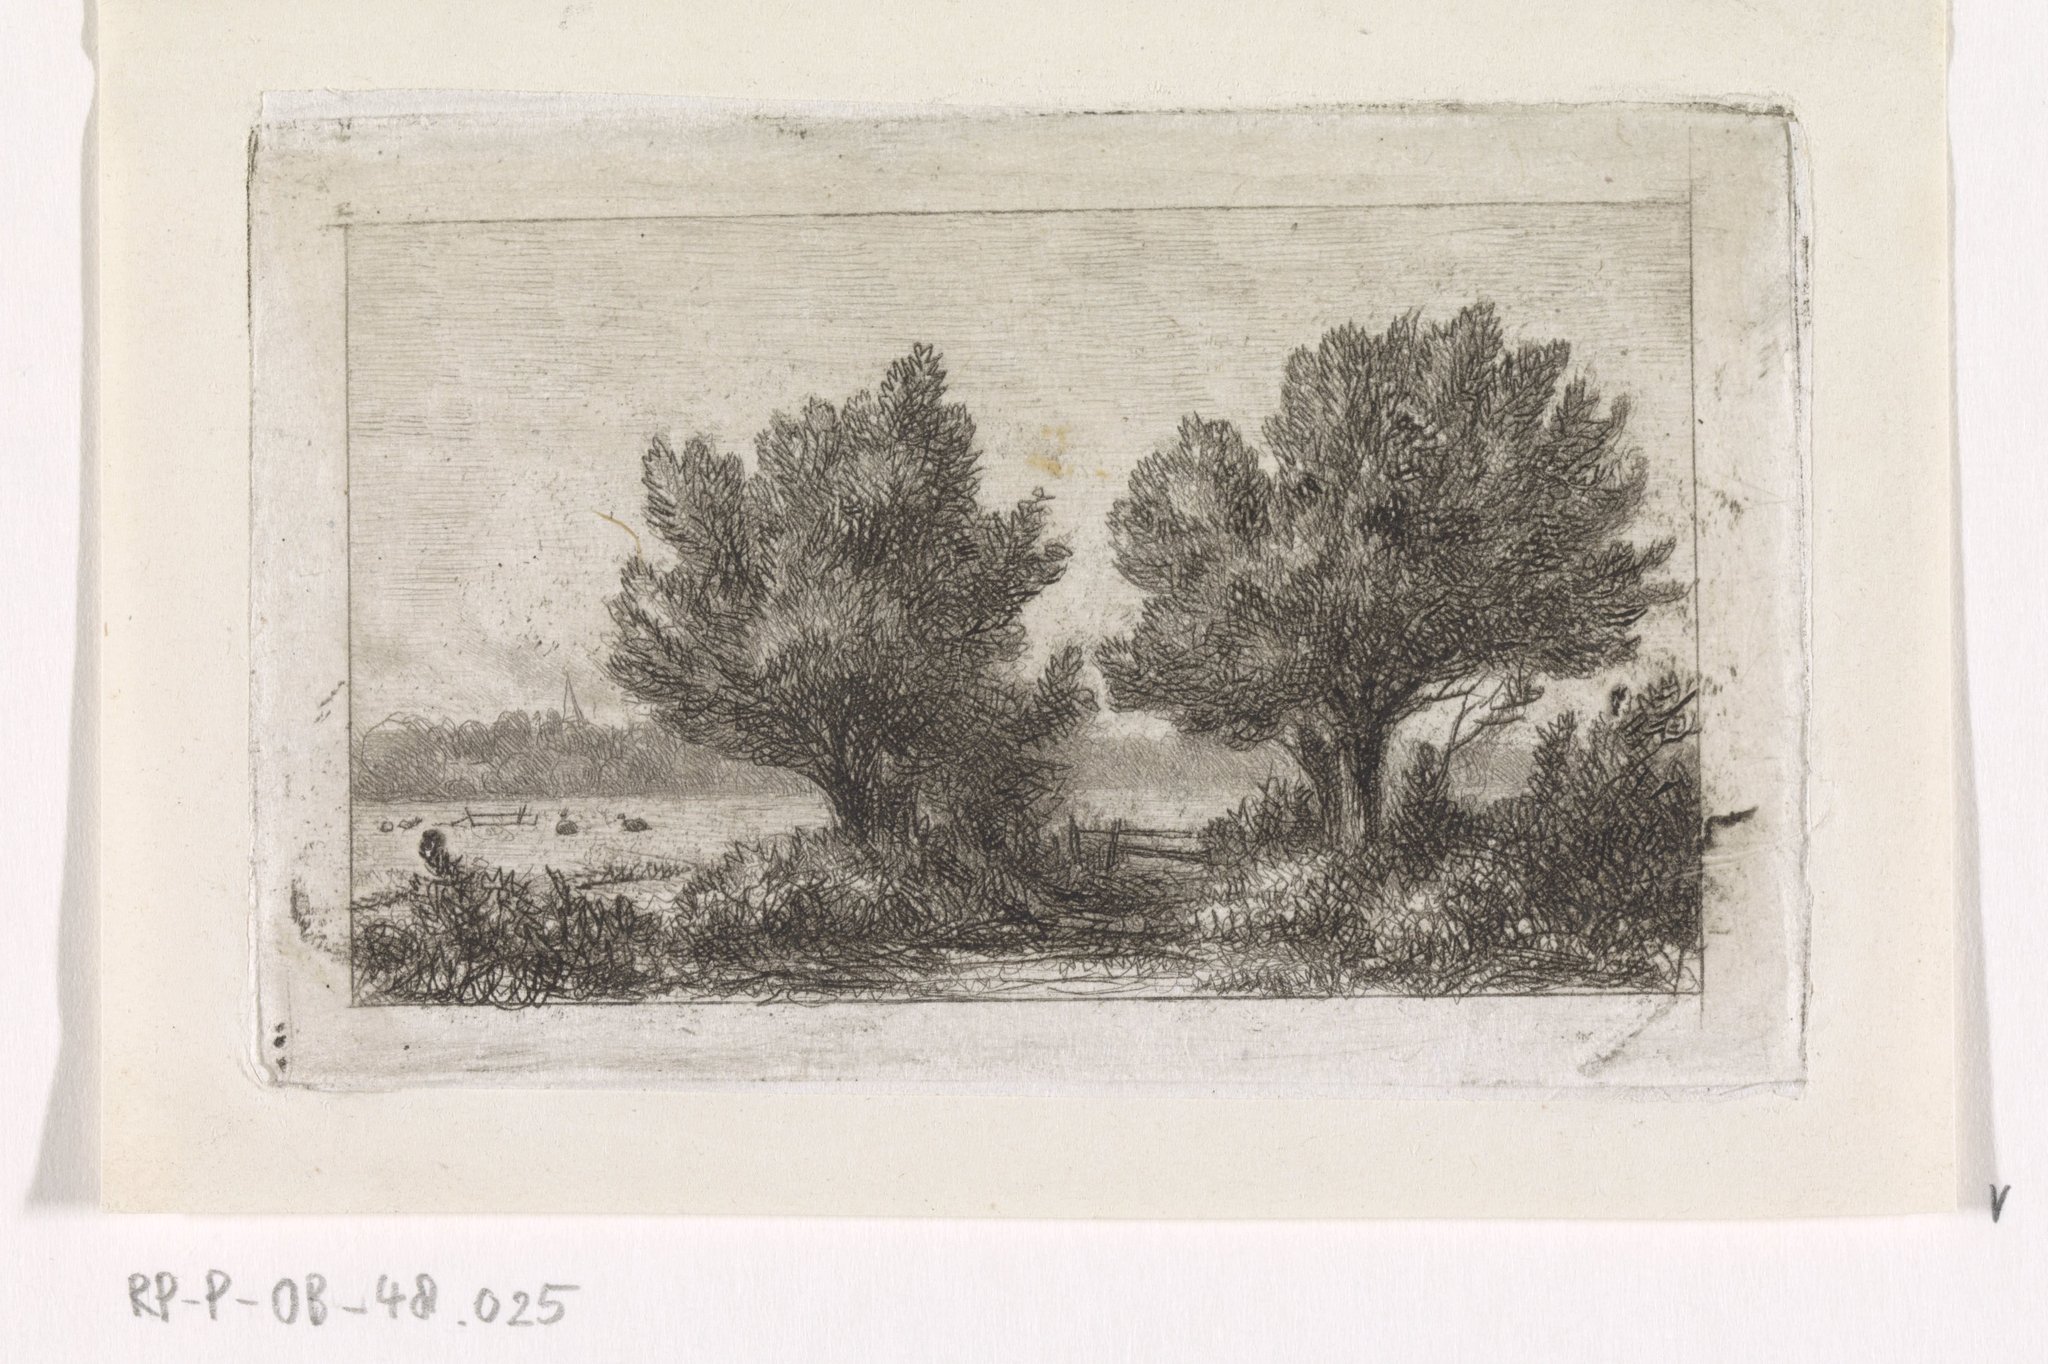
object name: print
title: Bomen in een weidelandschap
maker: jacob jan van der maaten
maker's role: draughtsman, print maker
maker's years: 1820-1879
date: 1851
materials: paper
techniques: etching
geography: the hague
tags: trees, meadow, pasture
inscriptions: collector's mark: Lugt 2228